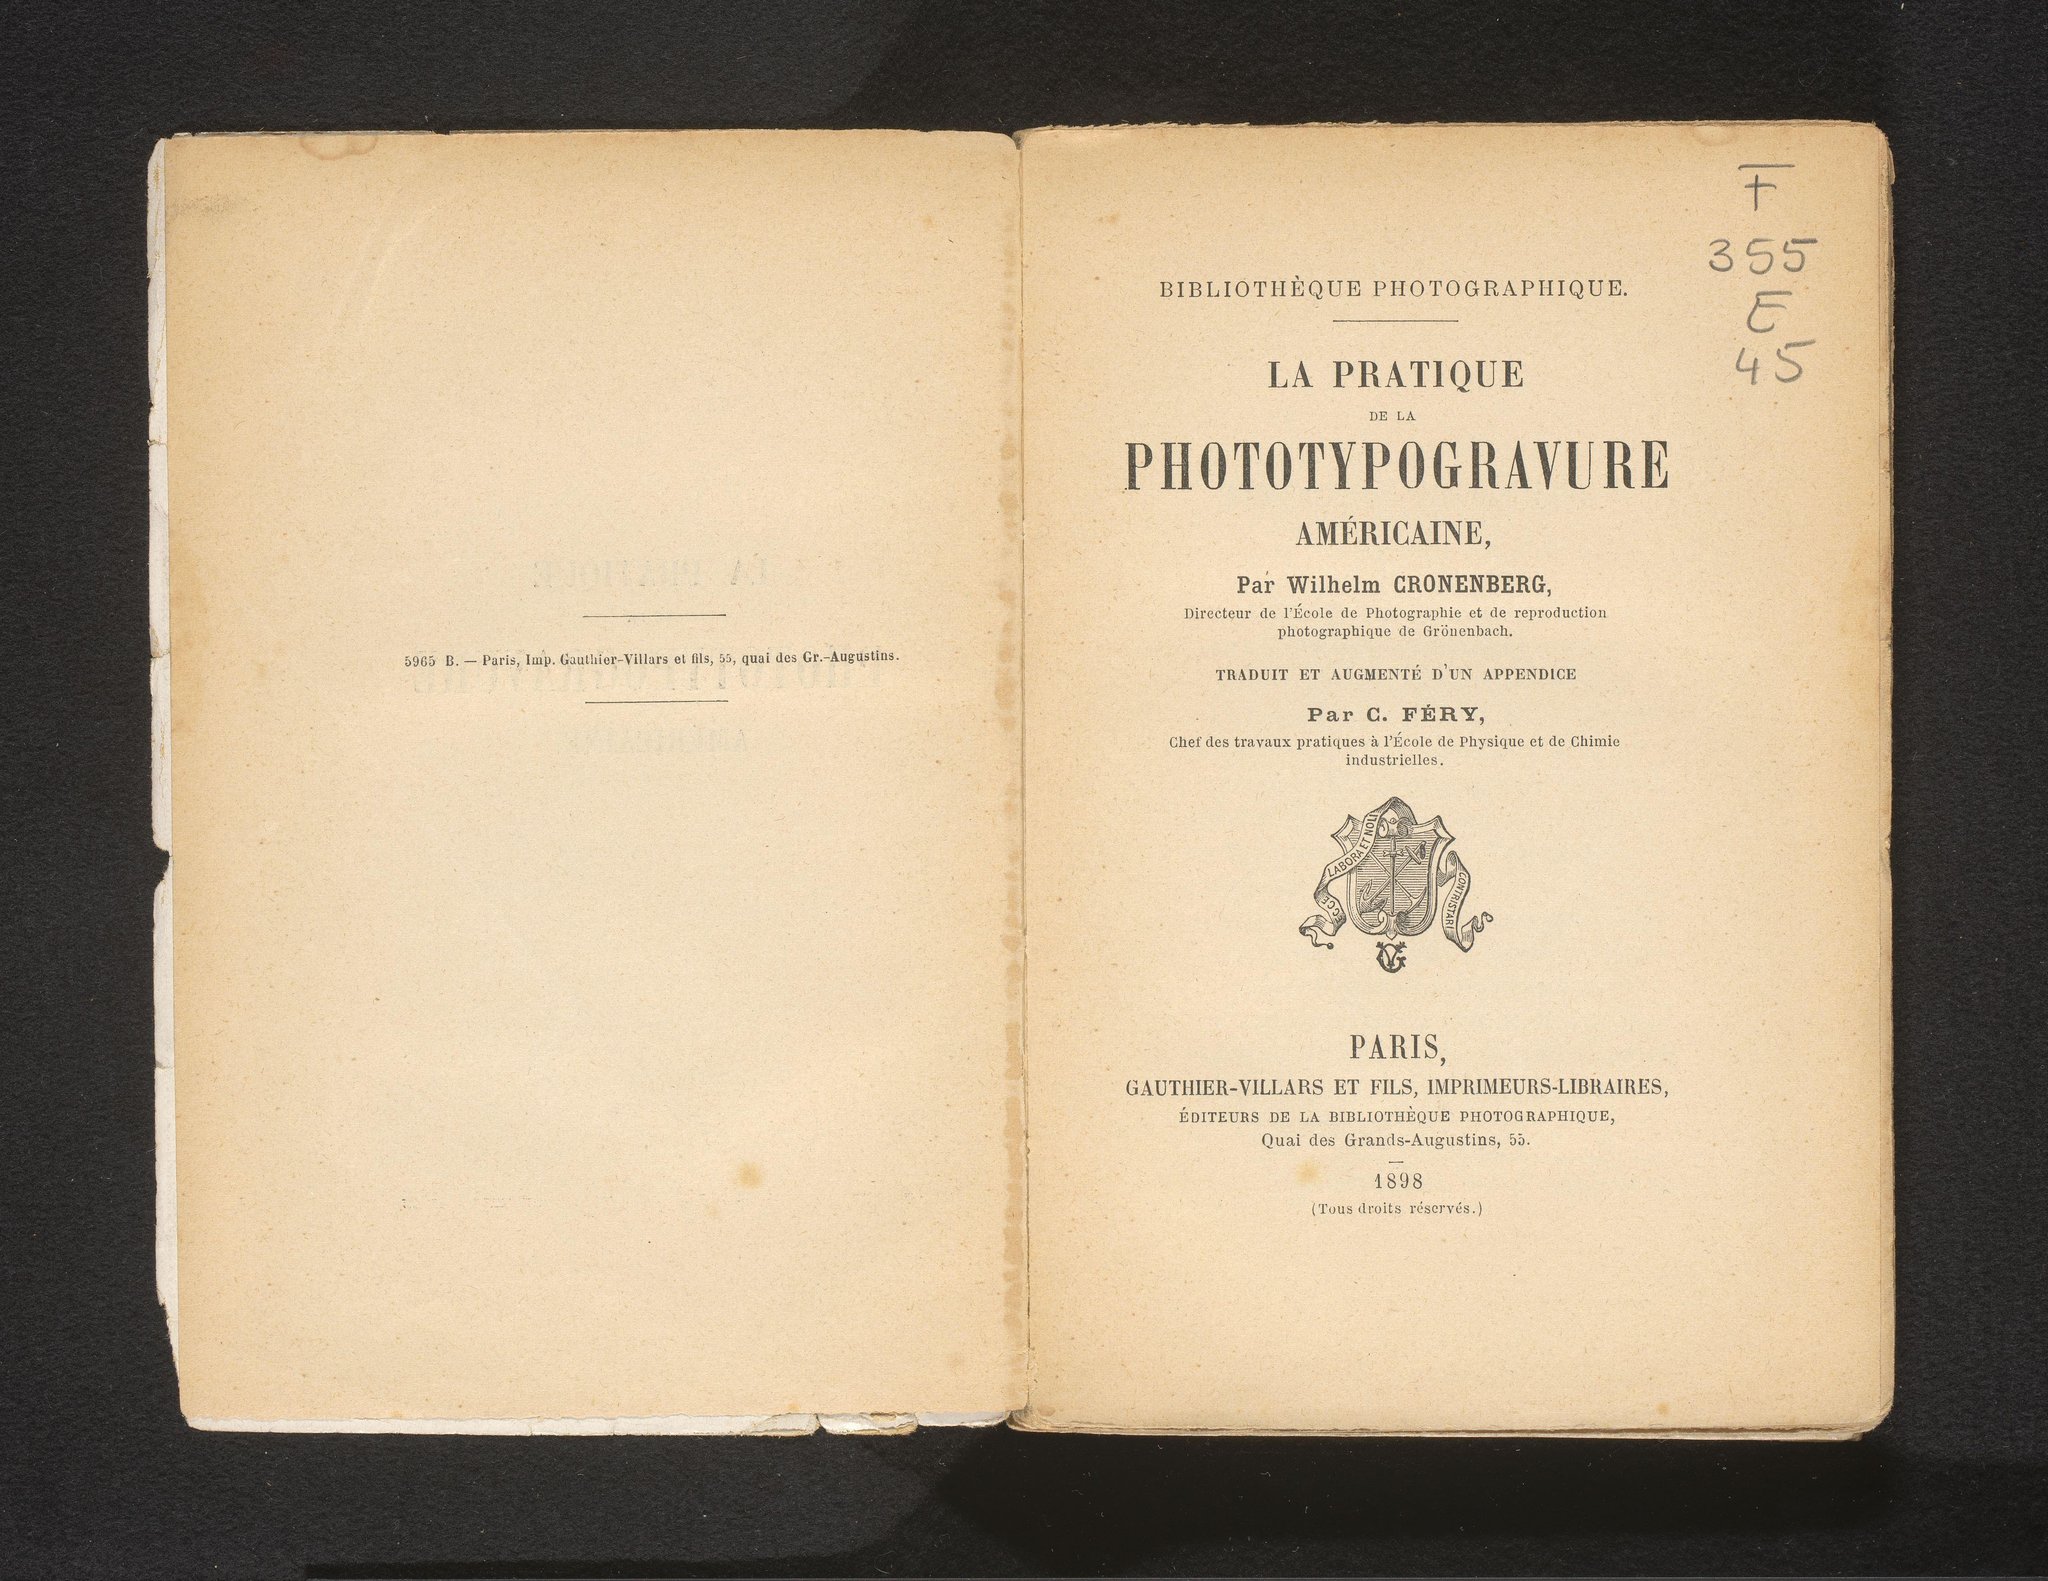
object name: book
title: La pratique de la phototypogravure américaine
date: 1898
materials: paper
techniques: printing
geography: paris